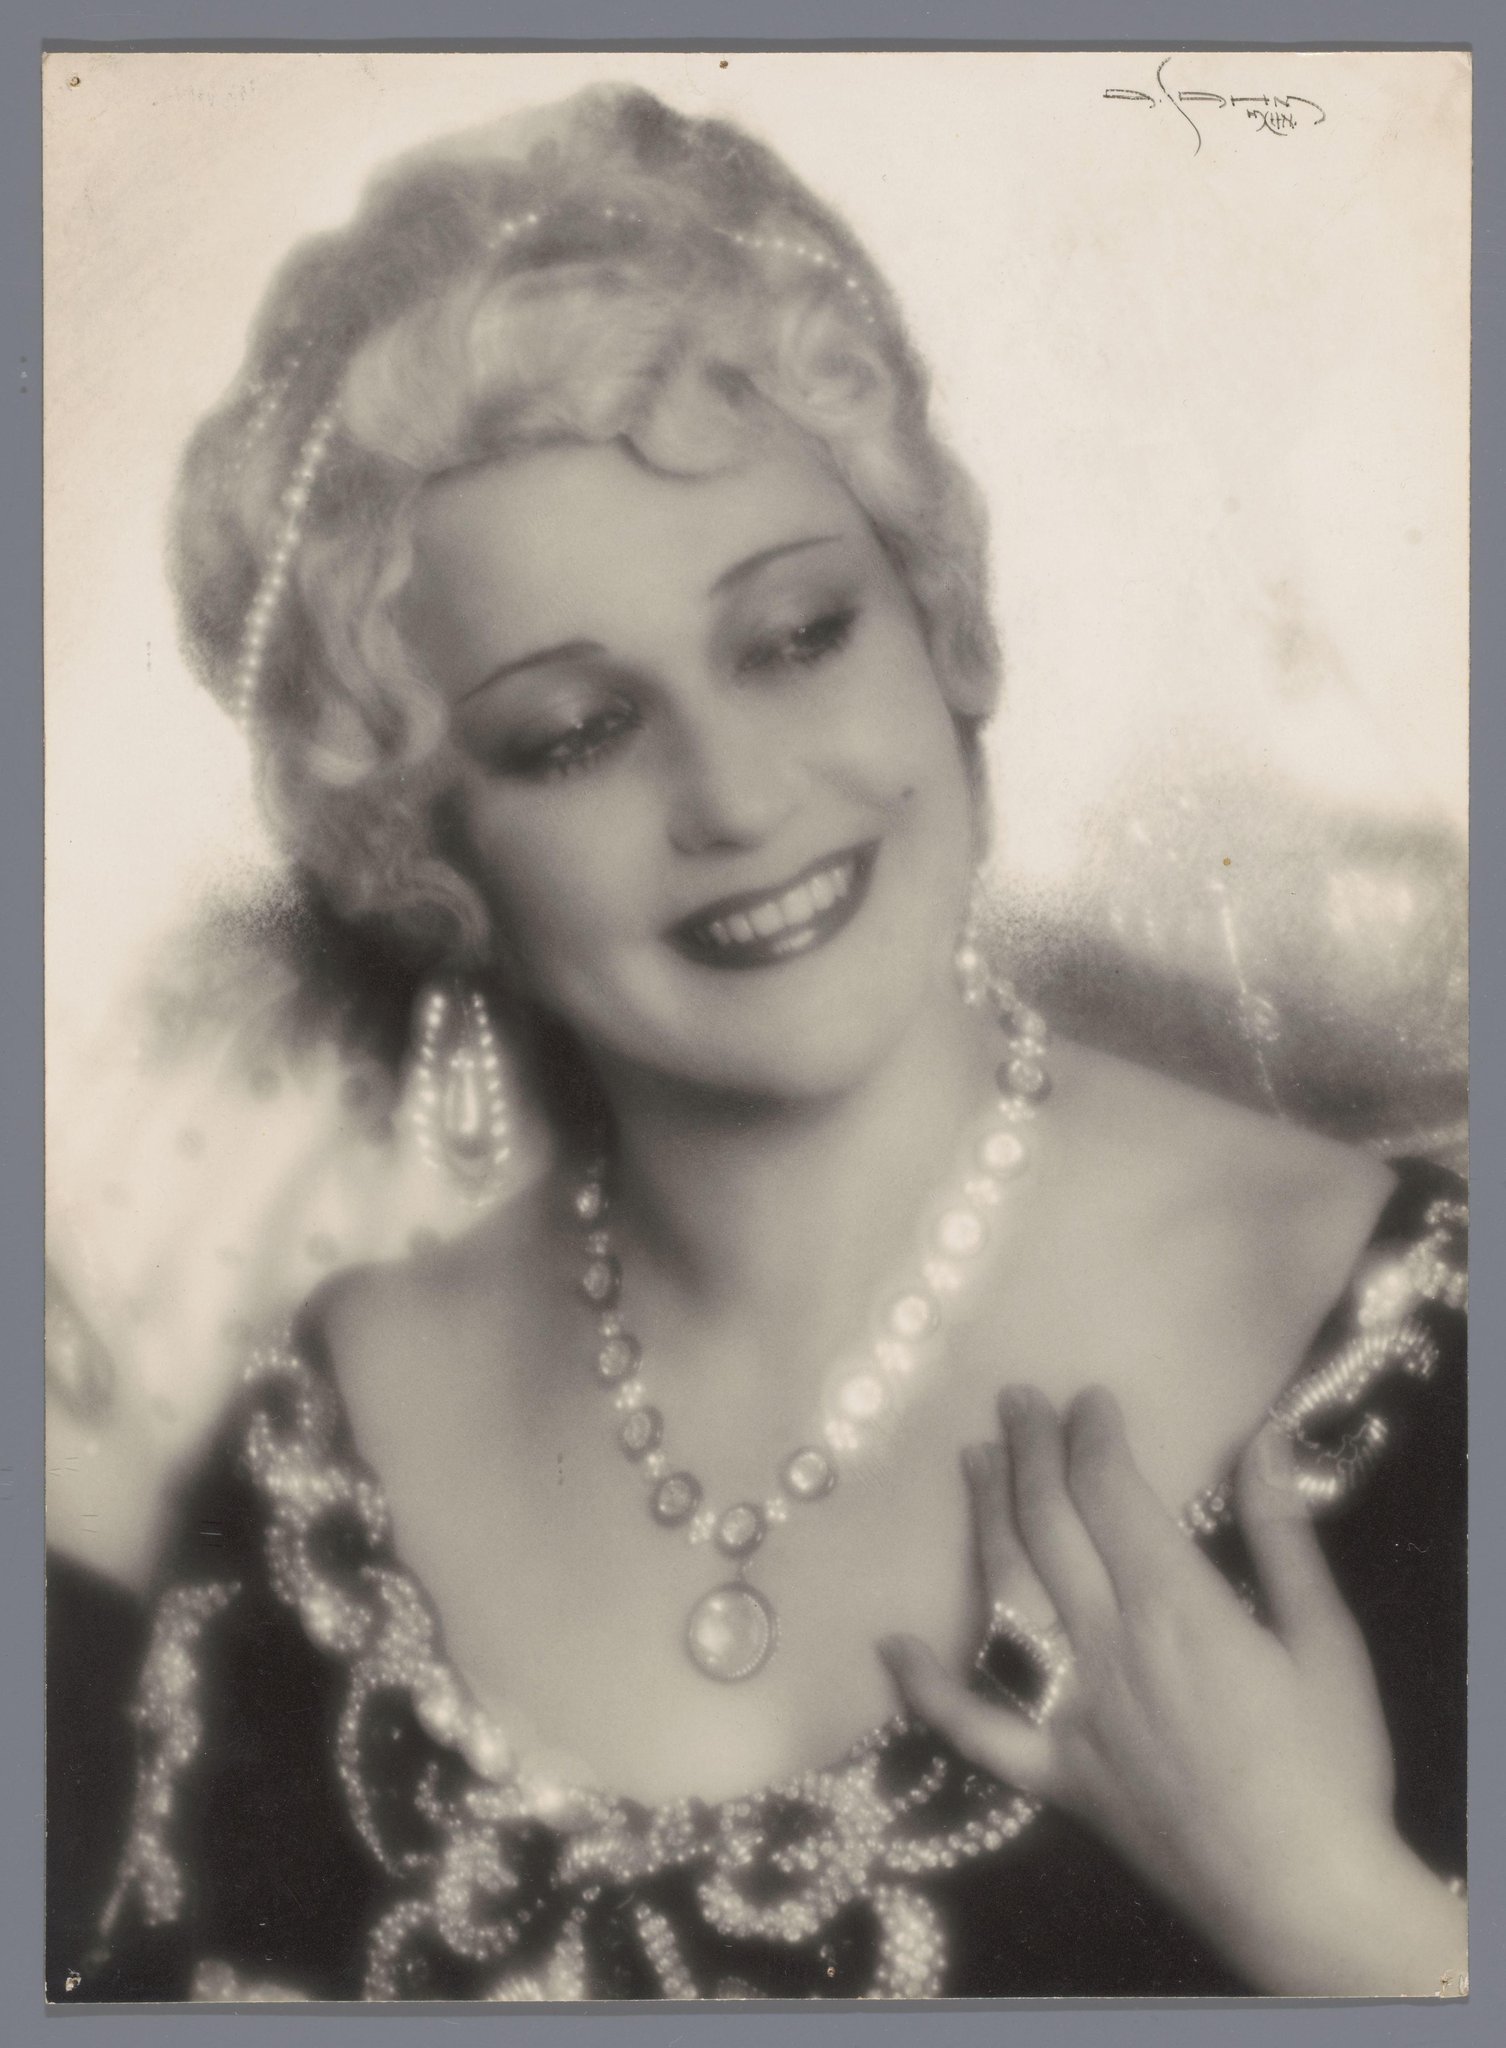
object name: photograph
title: Glamourportret vrouw met diverse juwelen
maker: anton sahm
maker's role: fotograaf, fotostudio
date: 1925-1935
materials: paper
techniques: gelatin silver print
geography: munich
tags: adult woman, putting on jewels - aa - (for) women, anonymous historical person portrayed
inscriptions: signature: ‘A. Sahm/ Mchn.’, stamp: ‘Vervielfältigung nur mit Angabe/ "Anton Sahm, München"/ gestattet. Das Honorar gilt für die/ einmalige Veröffentlichung./ Copyright by Anton Sahm, München.’